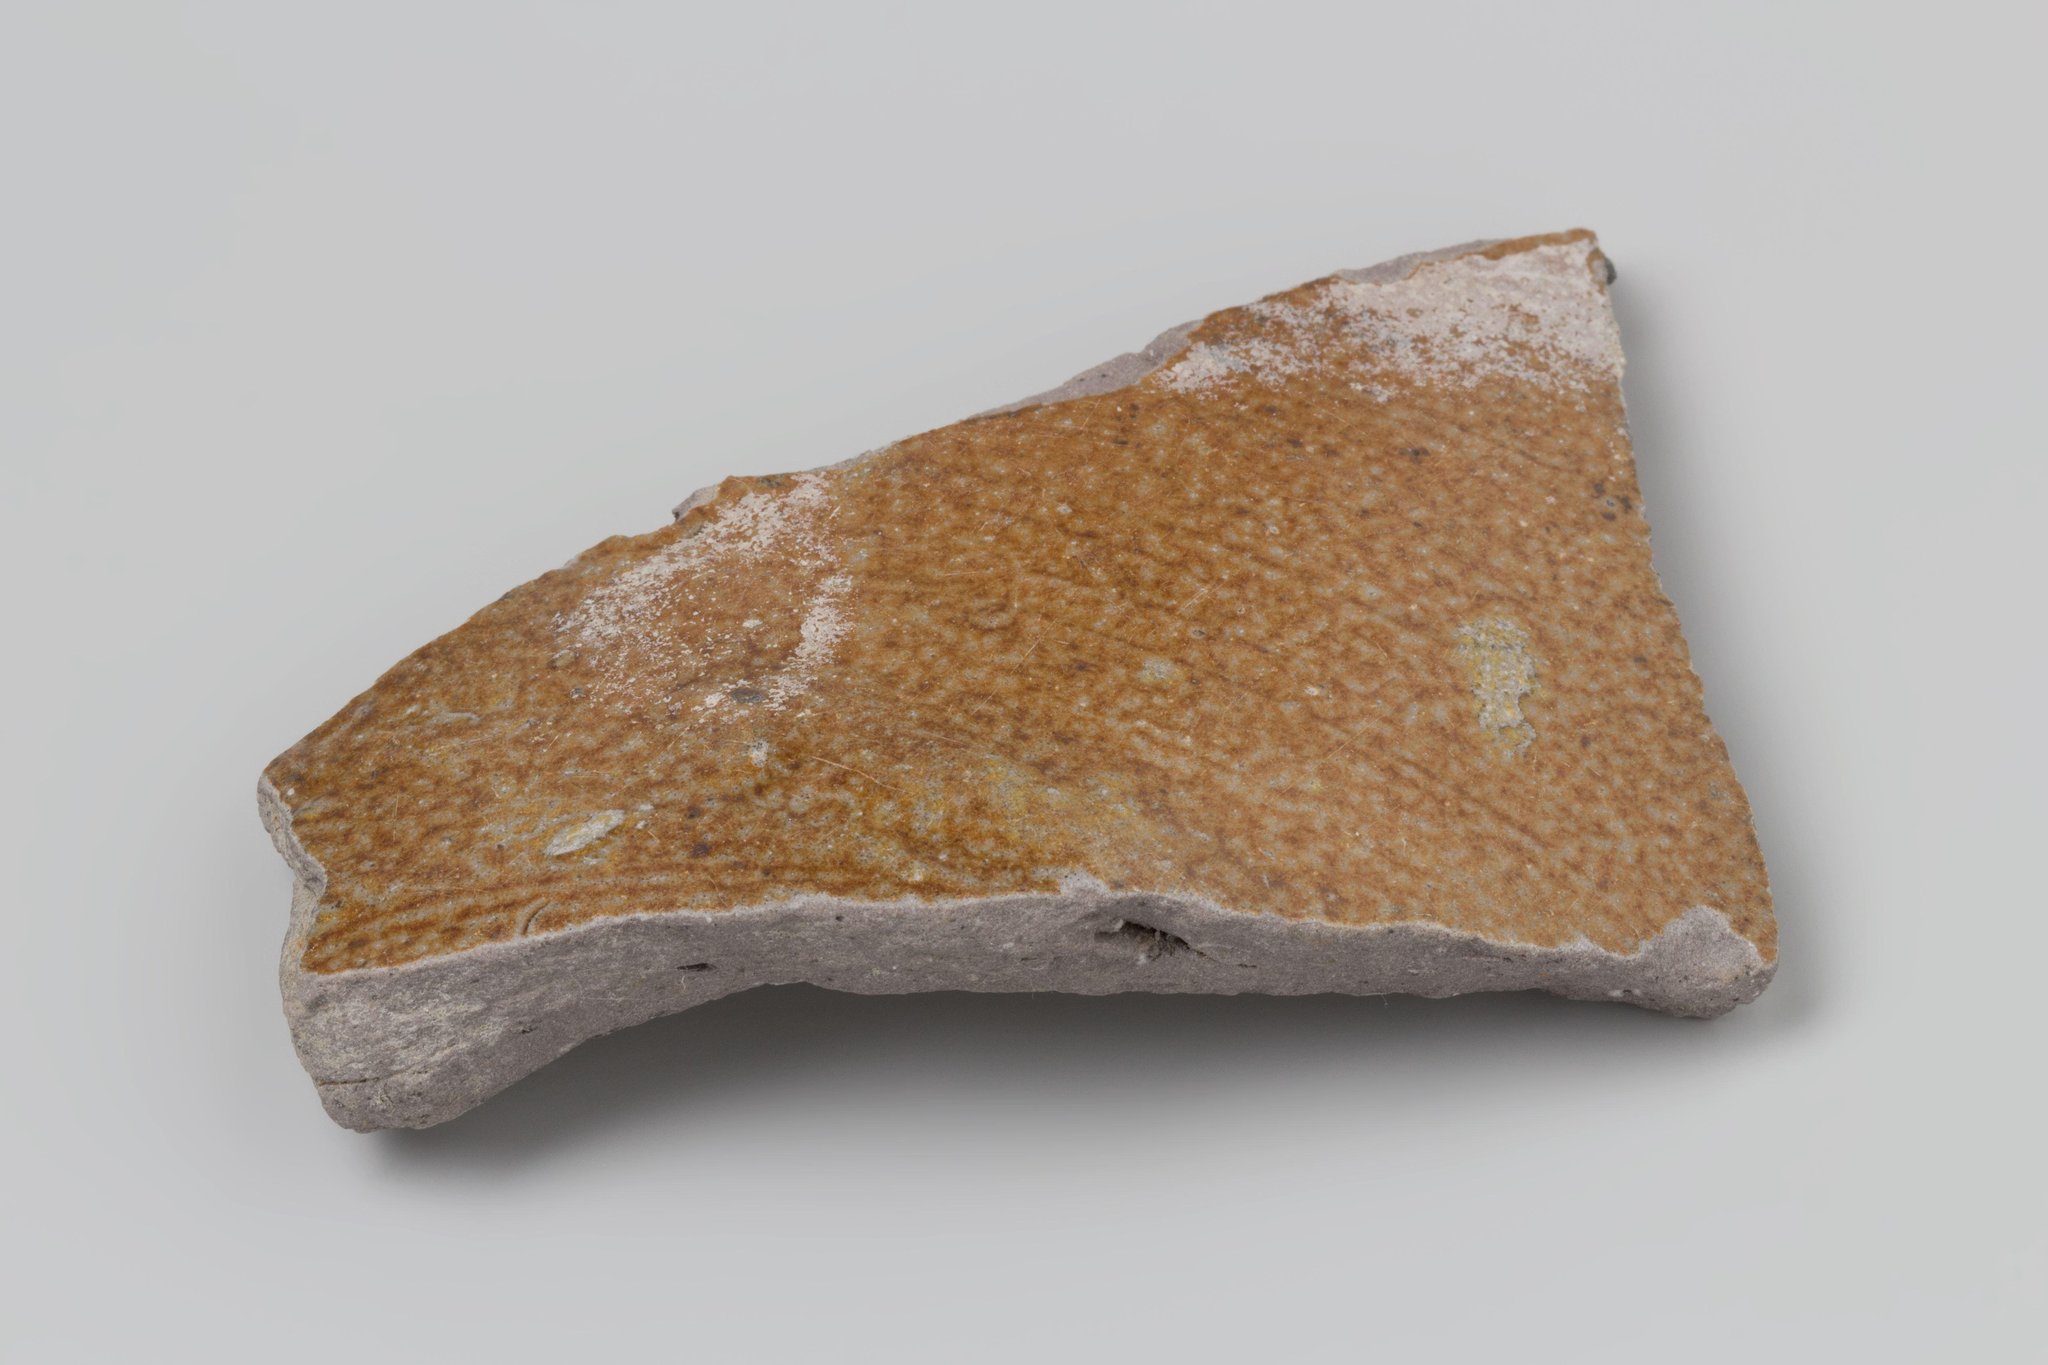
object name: sherd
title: Scherf uit het wrak van de Oost-Indiëvaarder 't Vliegend Hart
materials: glaze, stoneware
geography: netherlands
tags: 't vliegend hart (schip), verenigde oostindische compagnie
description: Licht gebogen scherf, buiten bruin gespikkeld, binnen loodgrijs. Stoneware.